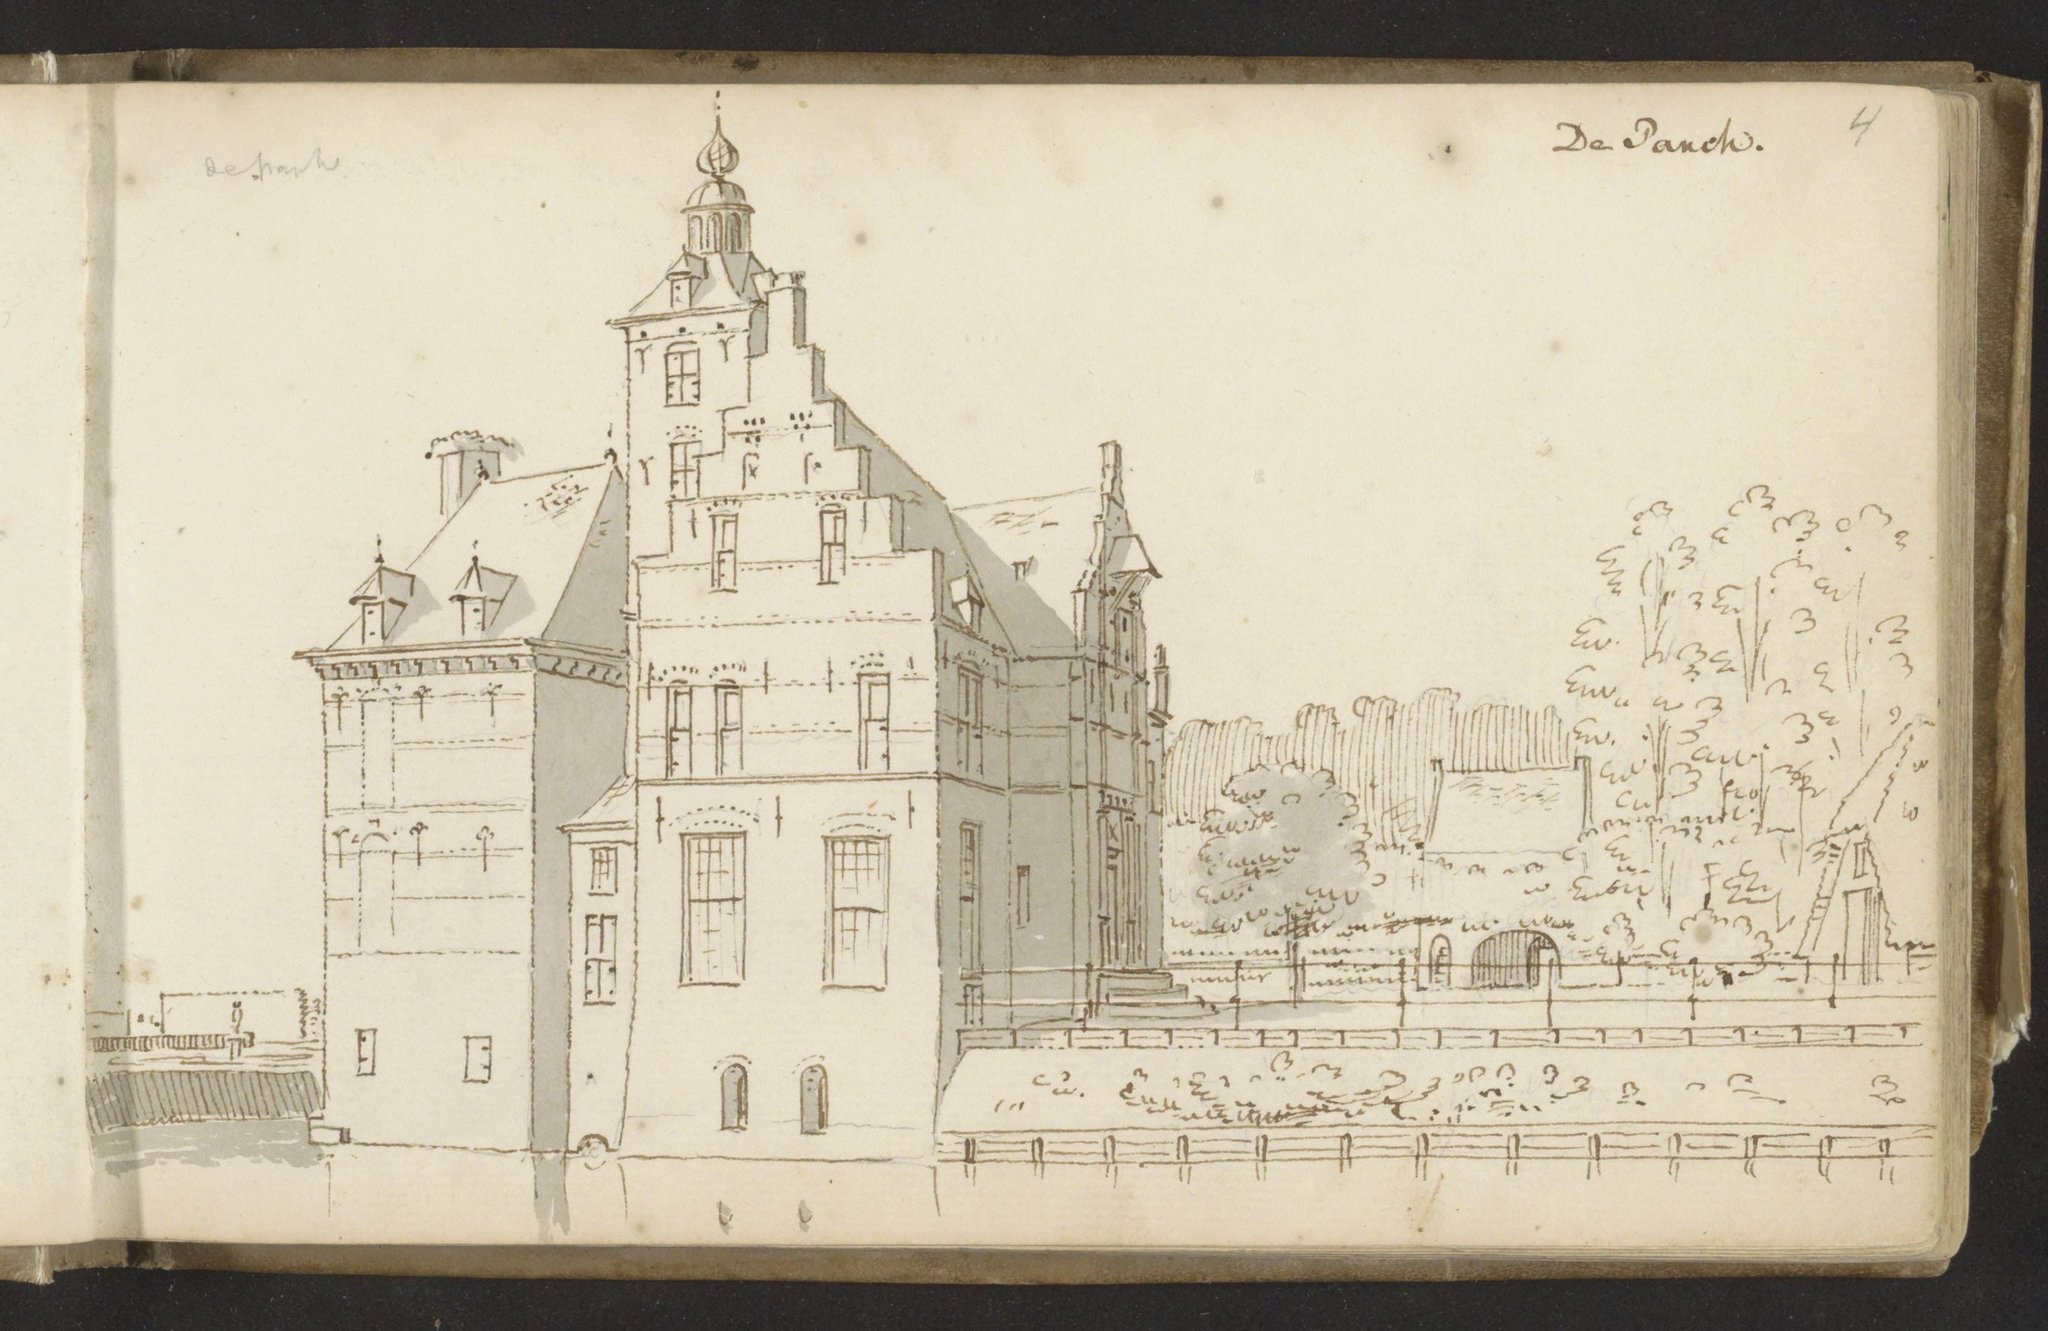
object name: sketchbook leaf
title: Kasteel De Parck te Elst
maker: abraham de haen (ii)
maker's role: draughtsman, print maker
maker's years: 1707-1748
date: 1731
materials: ink, paper, pencil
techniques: brush, pen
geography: elst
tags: castle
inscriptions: annotation: ‘de park/ De Parck.’, annotation: ‘De Park bij Elst/ gesloopt 1818.-’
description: Blad 4 recto uit een schetsboek met 69 bladen.